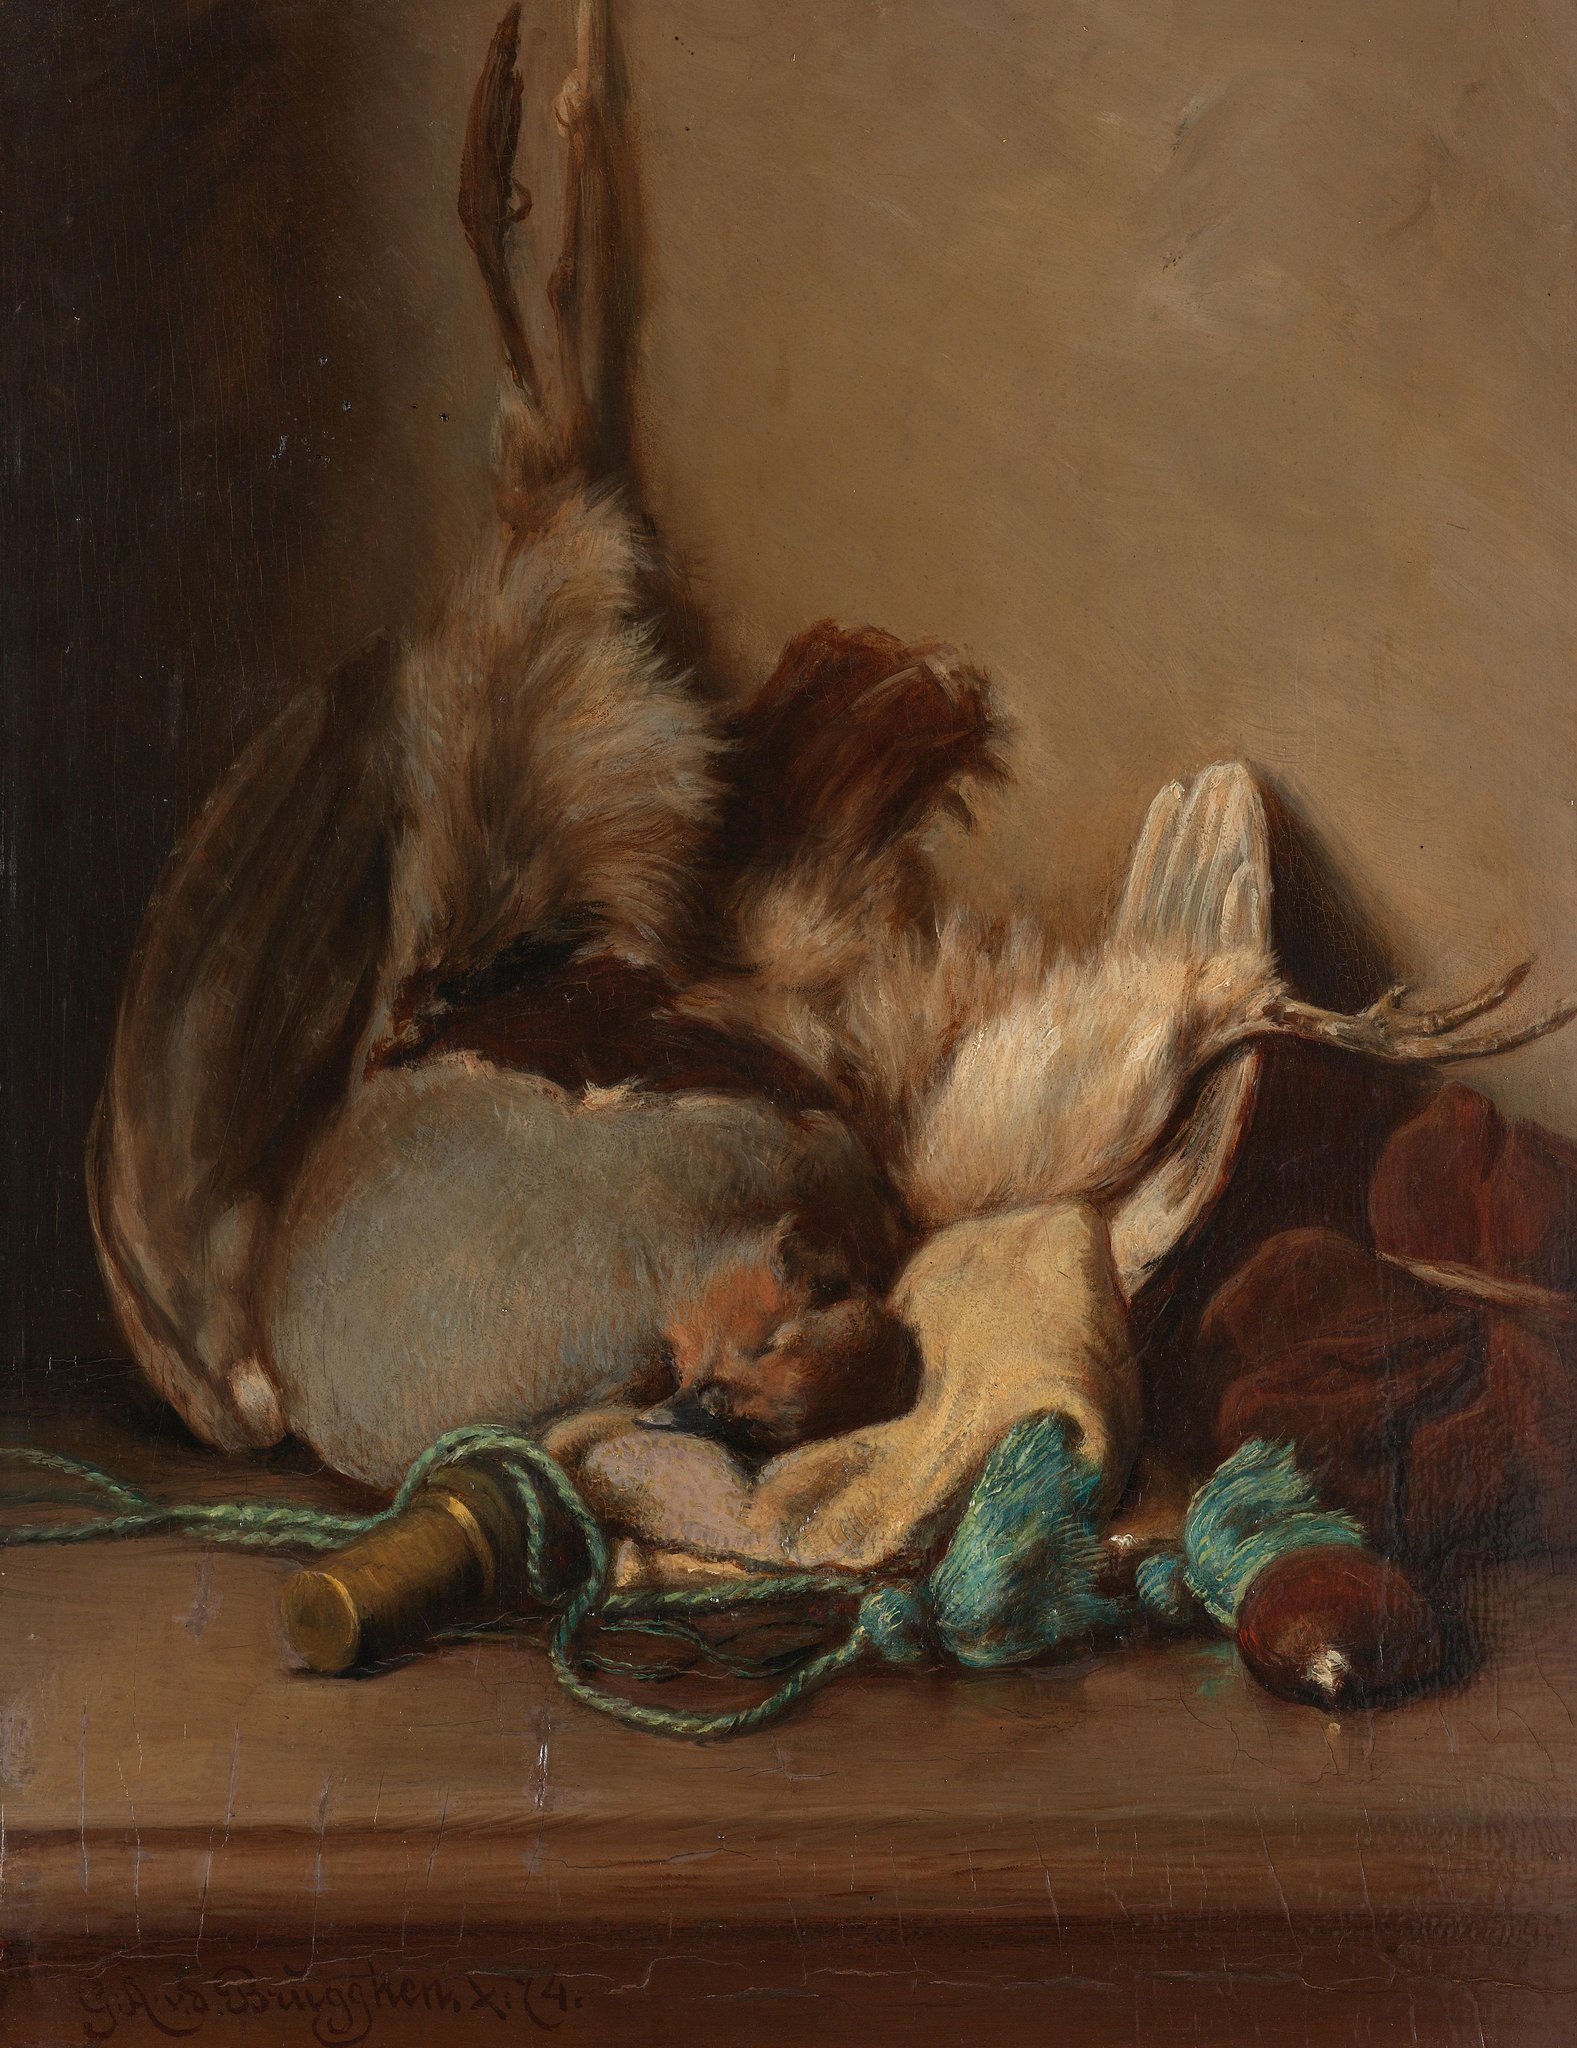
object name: painting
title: Still life with Wood Pigeon and Powder Horn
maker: guillaume anne van der brugghen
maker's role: draughtsman, print maker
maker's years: 1812-1891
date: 1874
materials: oil, panel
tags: still life of related objects, hunting trophies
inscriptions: signature and date: ‘G:A: v.d. Brugghen f: 74.’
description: Stilleven met een duif opgehangen aan een poot en een kruithoorn.